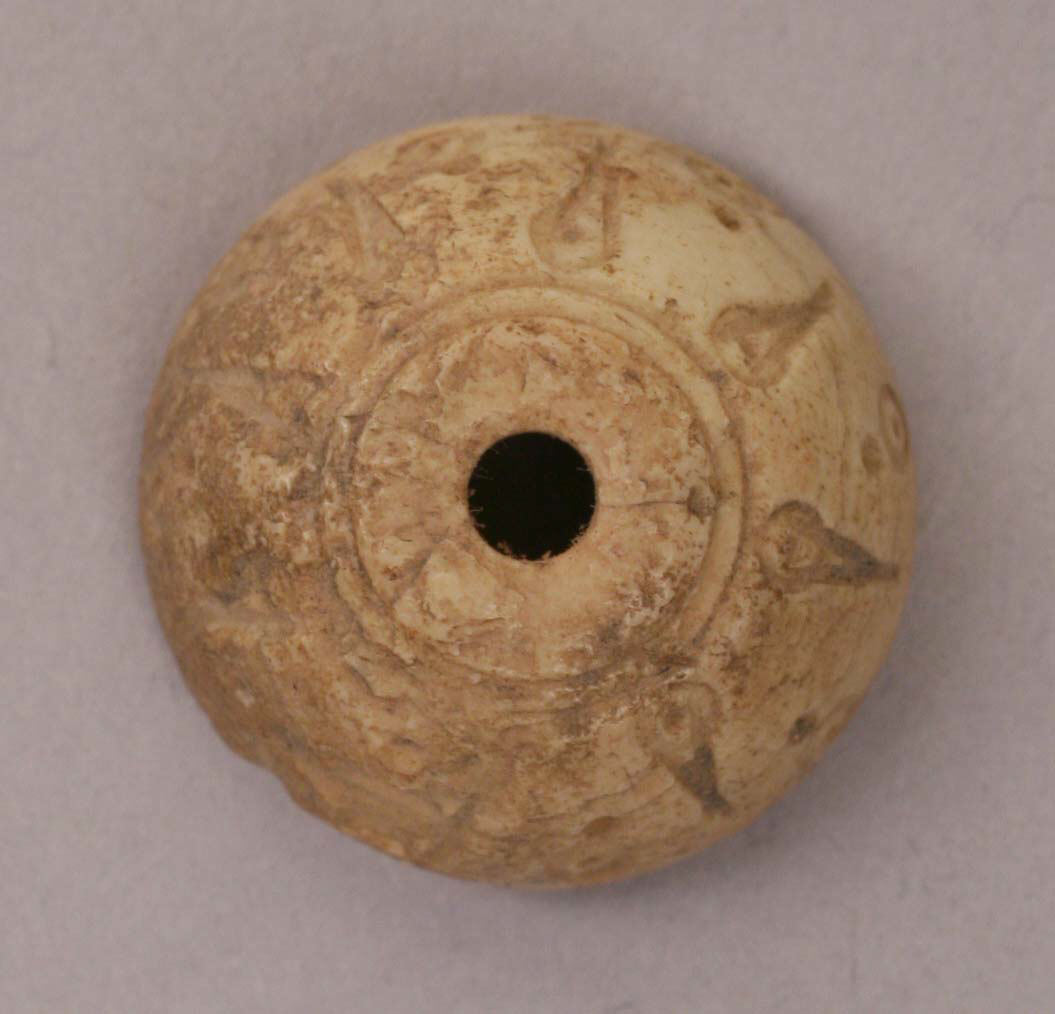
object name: button or bead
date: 801-1000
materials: bone, paint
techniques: incising, inlay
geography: iran